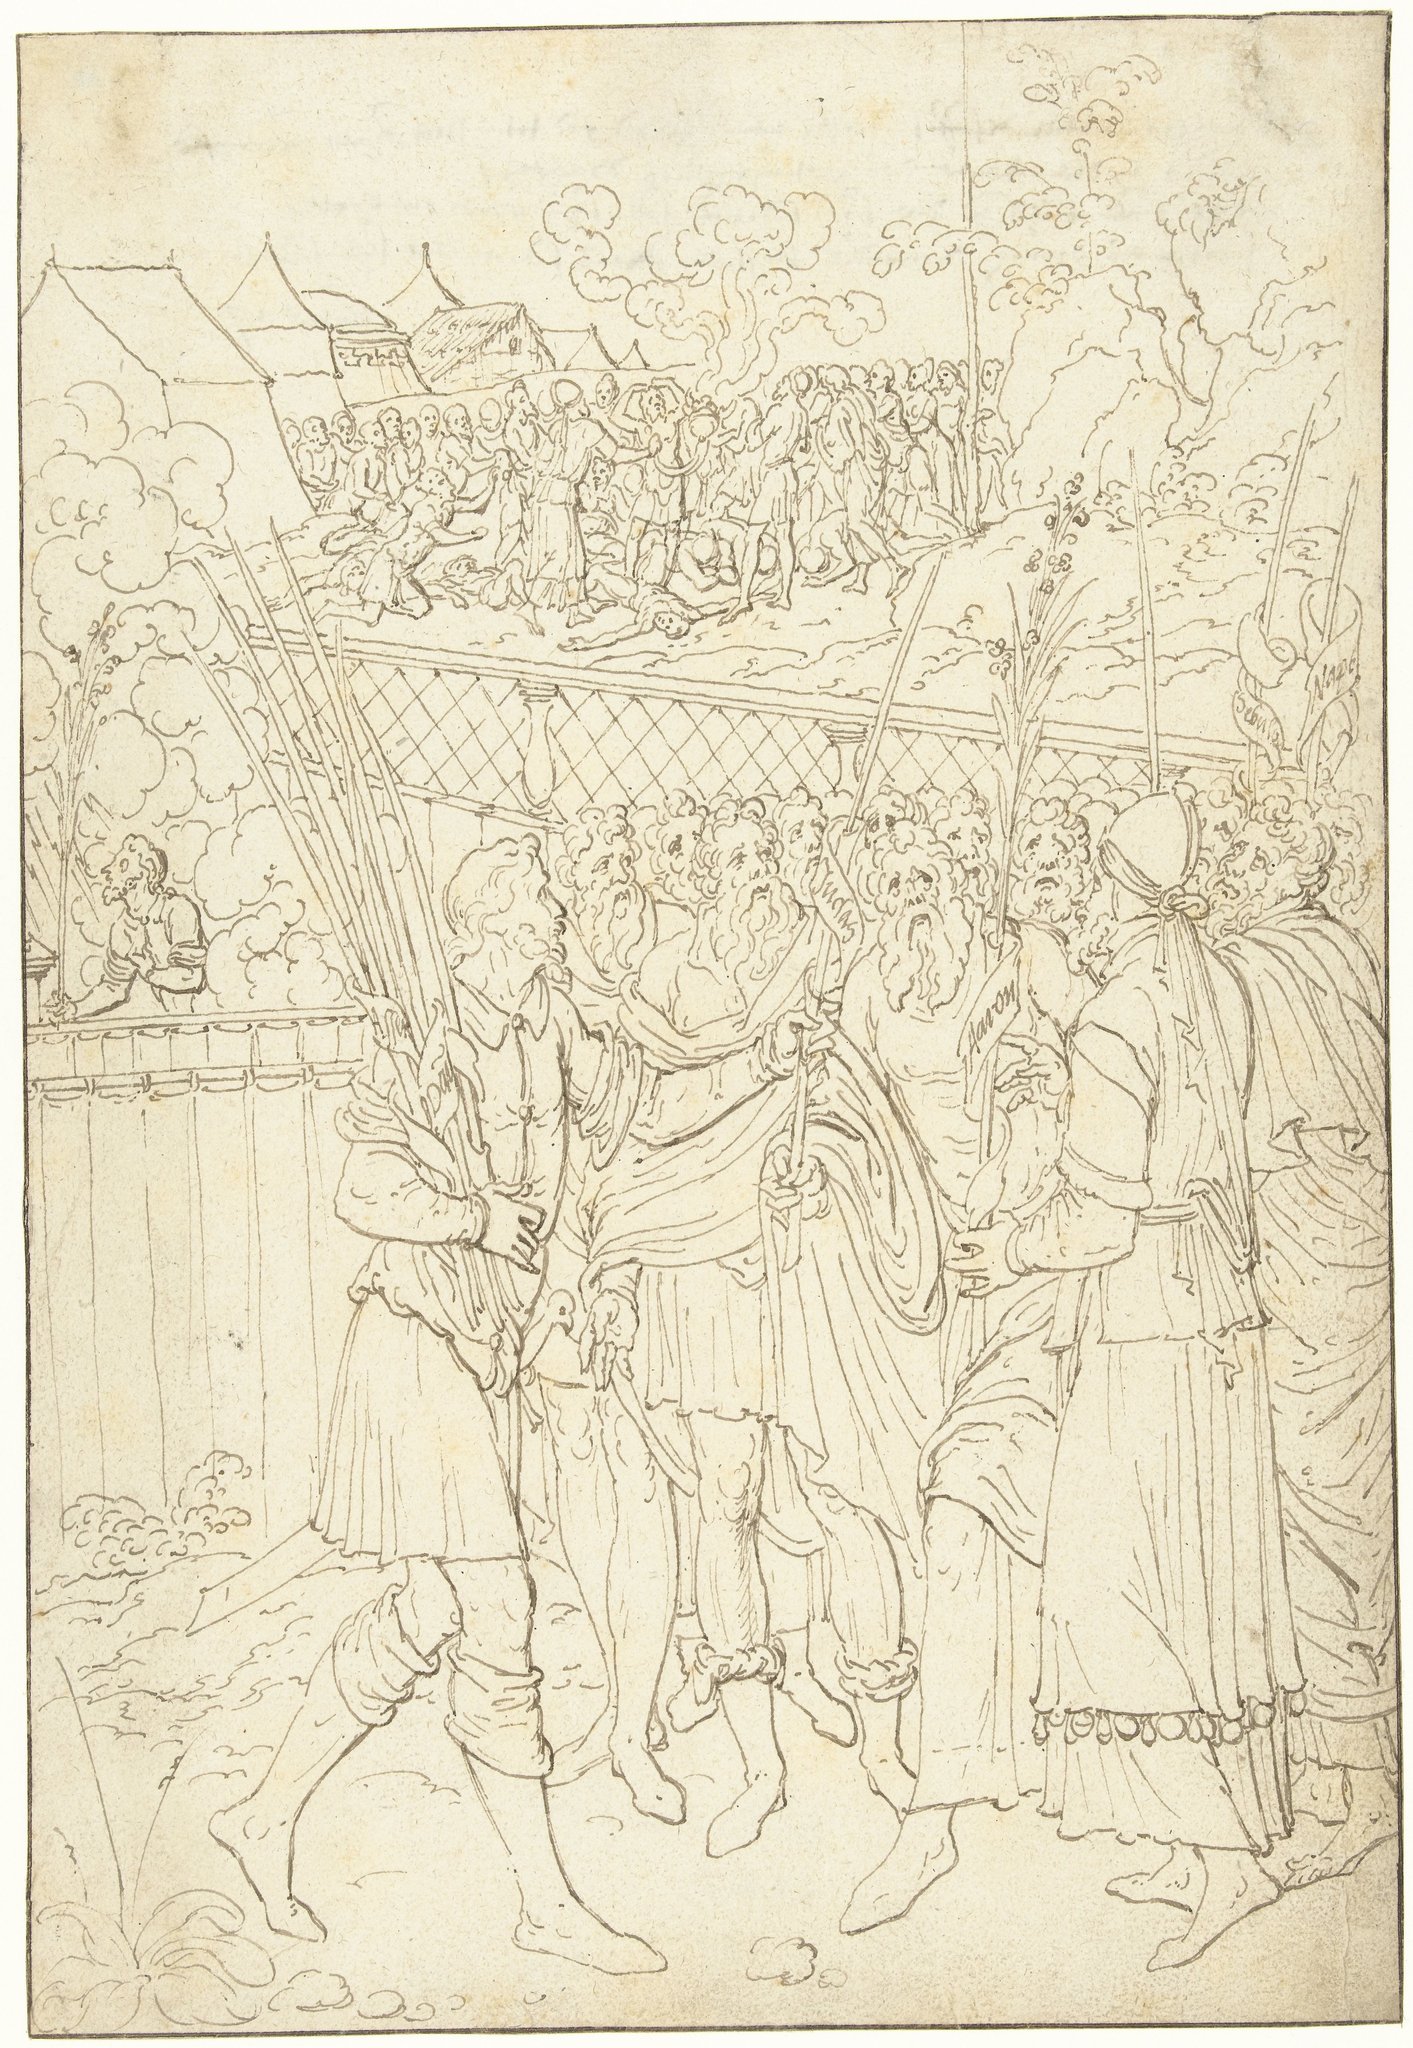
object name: drawing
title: Bloeiende staf van Aäron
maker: Anonymous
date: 1545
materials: ink, paper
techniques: pen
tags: aaron's rod has sprouted, flowered and produced ripe almonds